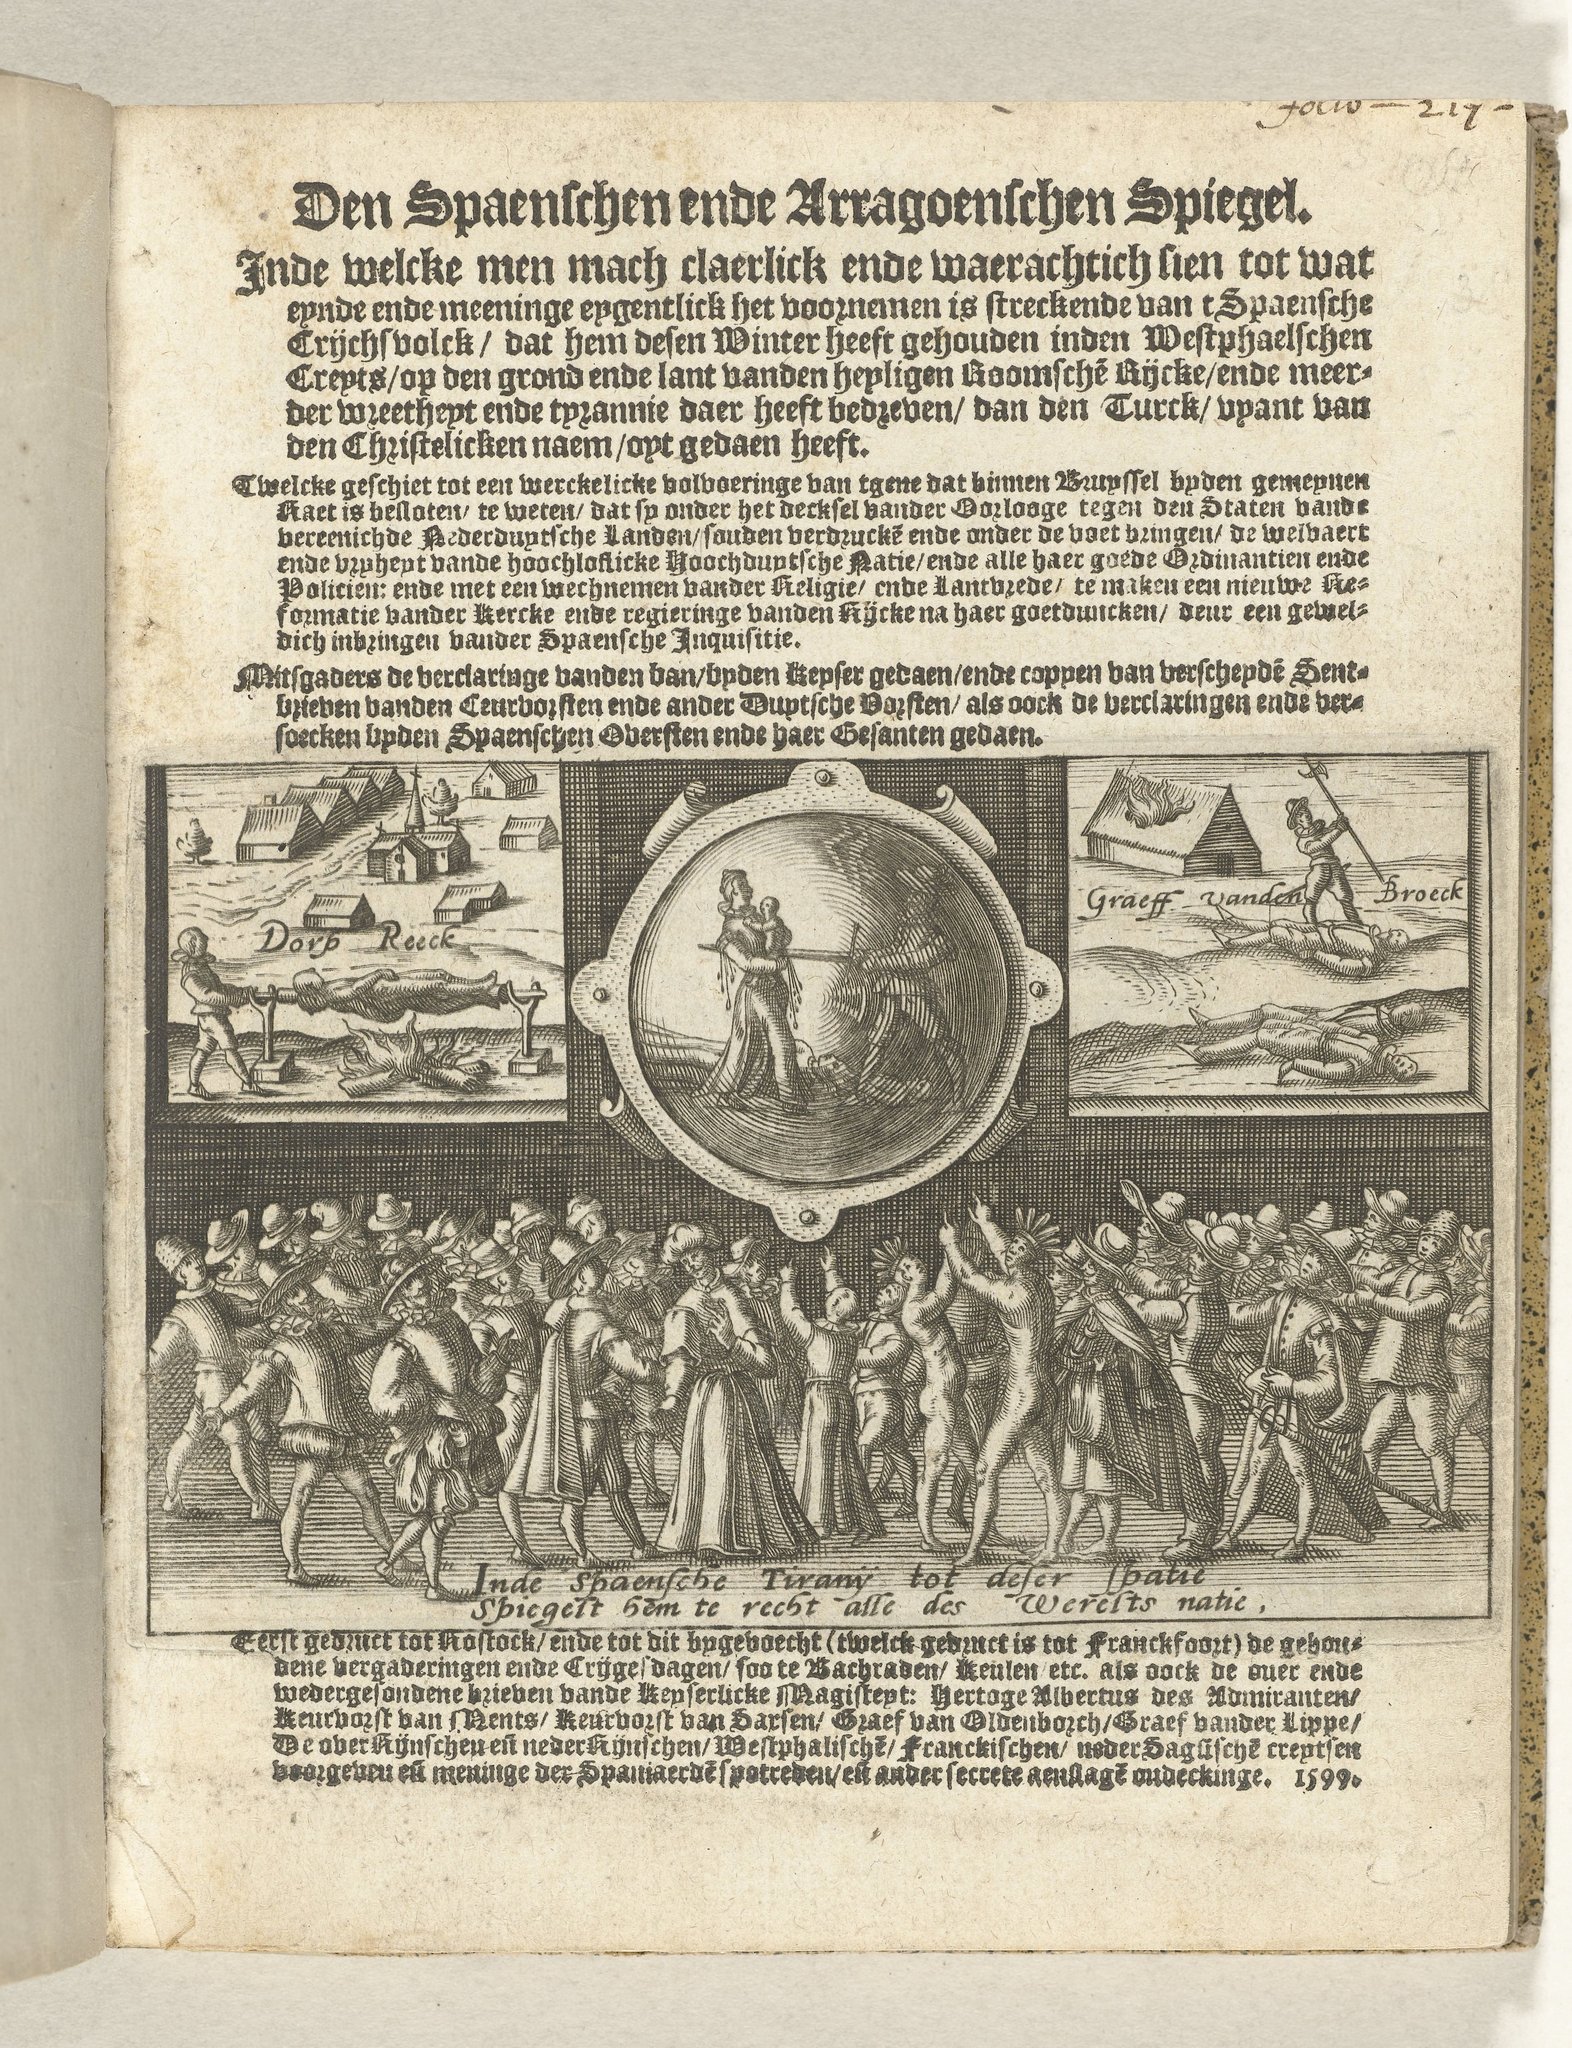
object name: titelblad, titelpagina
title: Titelpagina van het pamflet: Den Spaenschen ende Arragoenschen spiegel. Inde welcke men mach claerlick ende waerachtich sien tot wat eynde (...) het voornemen is (...) van 't Spaensche Crijchsvolck, dat hem desen Winter heeft gehouden in den Westphaelschen Creyts, 1599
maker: Anonymous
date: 1599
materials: paper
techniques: engraving, letterpress printing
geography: low countries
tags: title-page, torture, violent death, being killed; being mishandled and maltreated; seeking death, native peoples of the americas